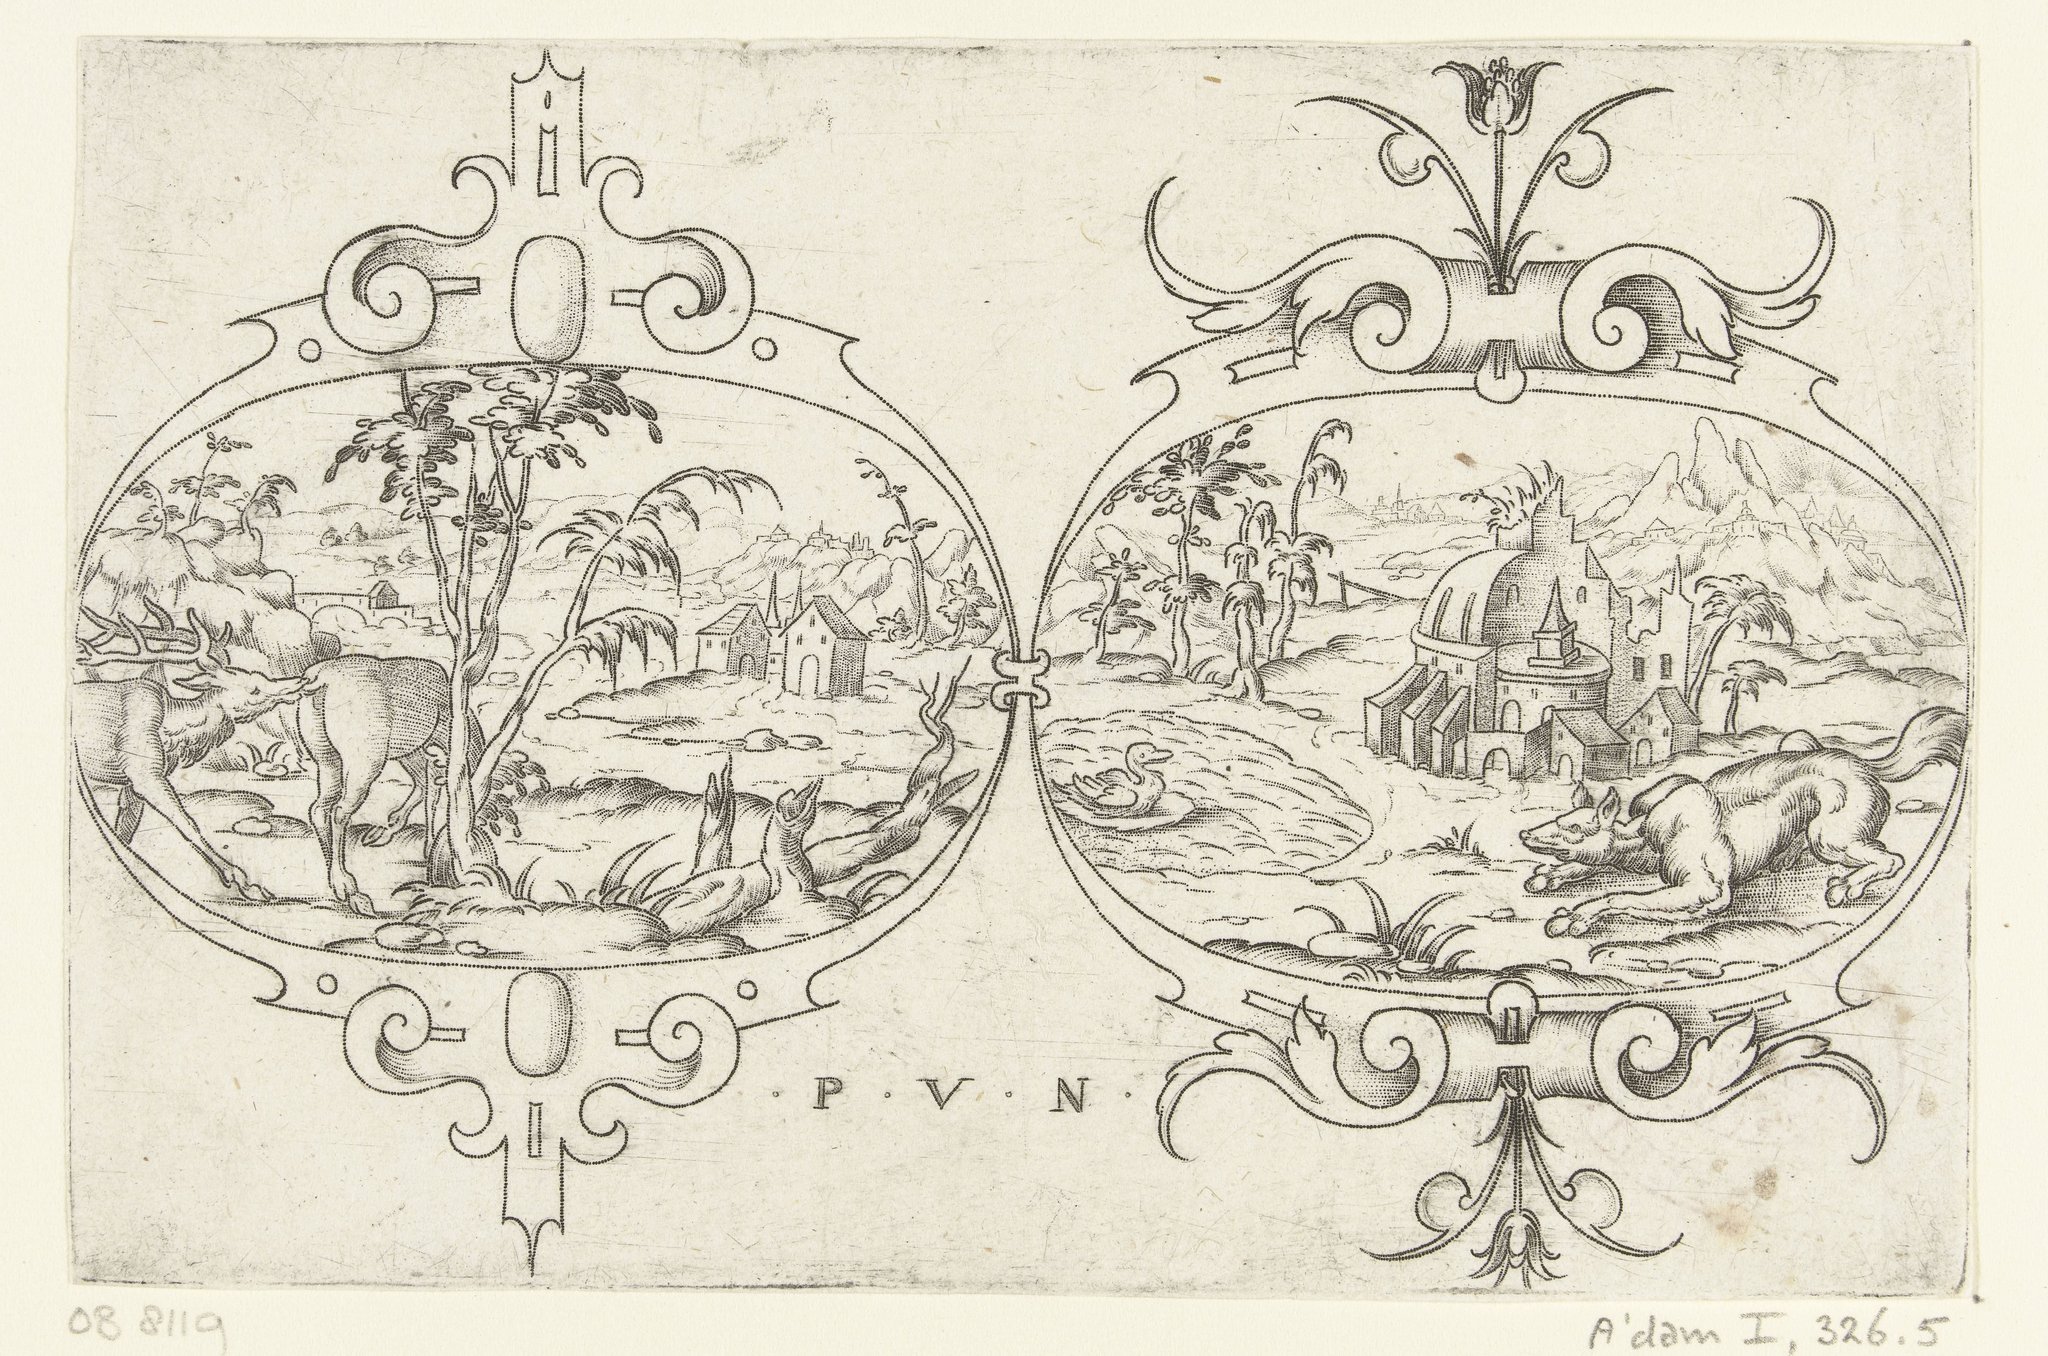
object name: print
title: Twee liggende ovalen, links met herten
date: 1600-1699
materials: paper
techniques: engraving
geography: germany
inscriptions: collector's mark: Lugt 240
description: Ovaal rechts met een eend en een hond. Uit serie van 12 bladen.